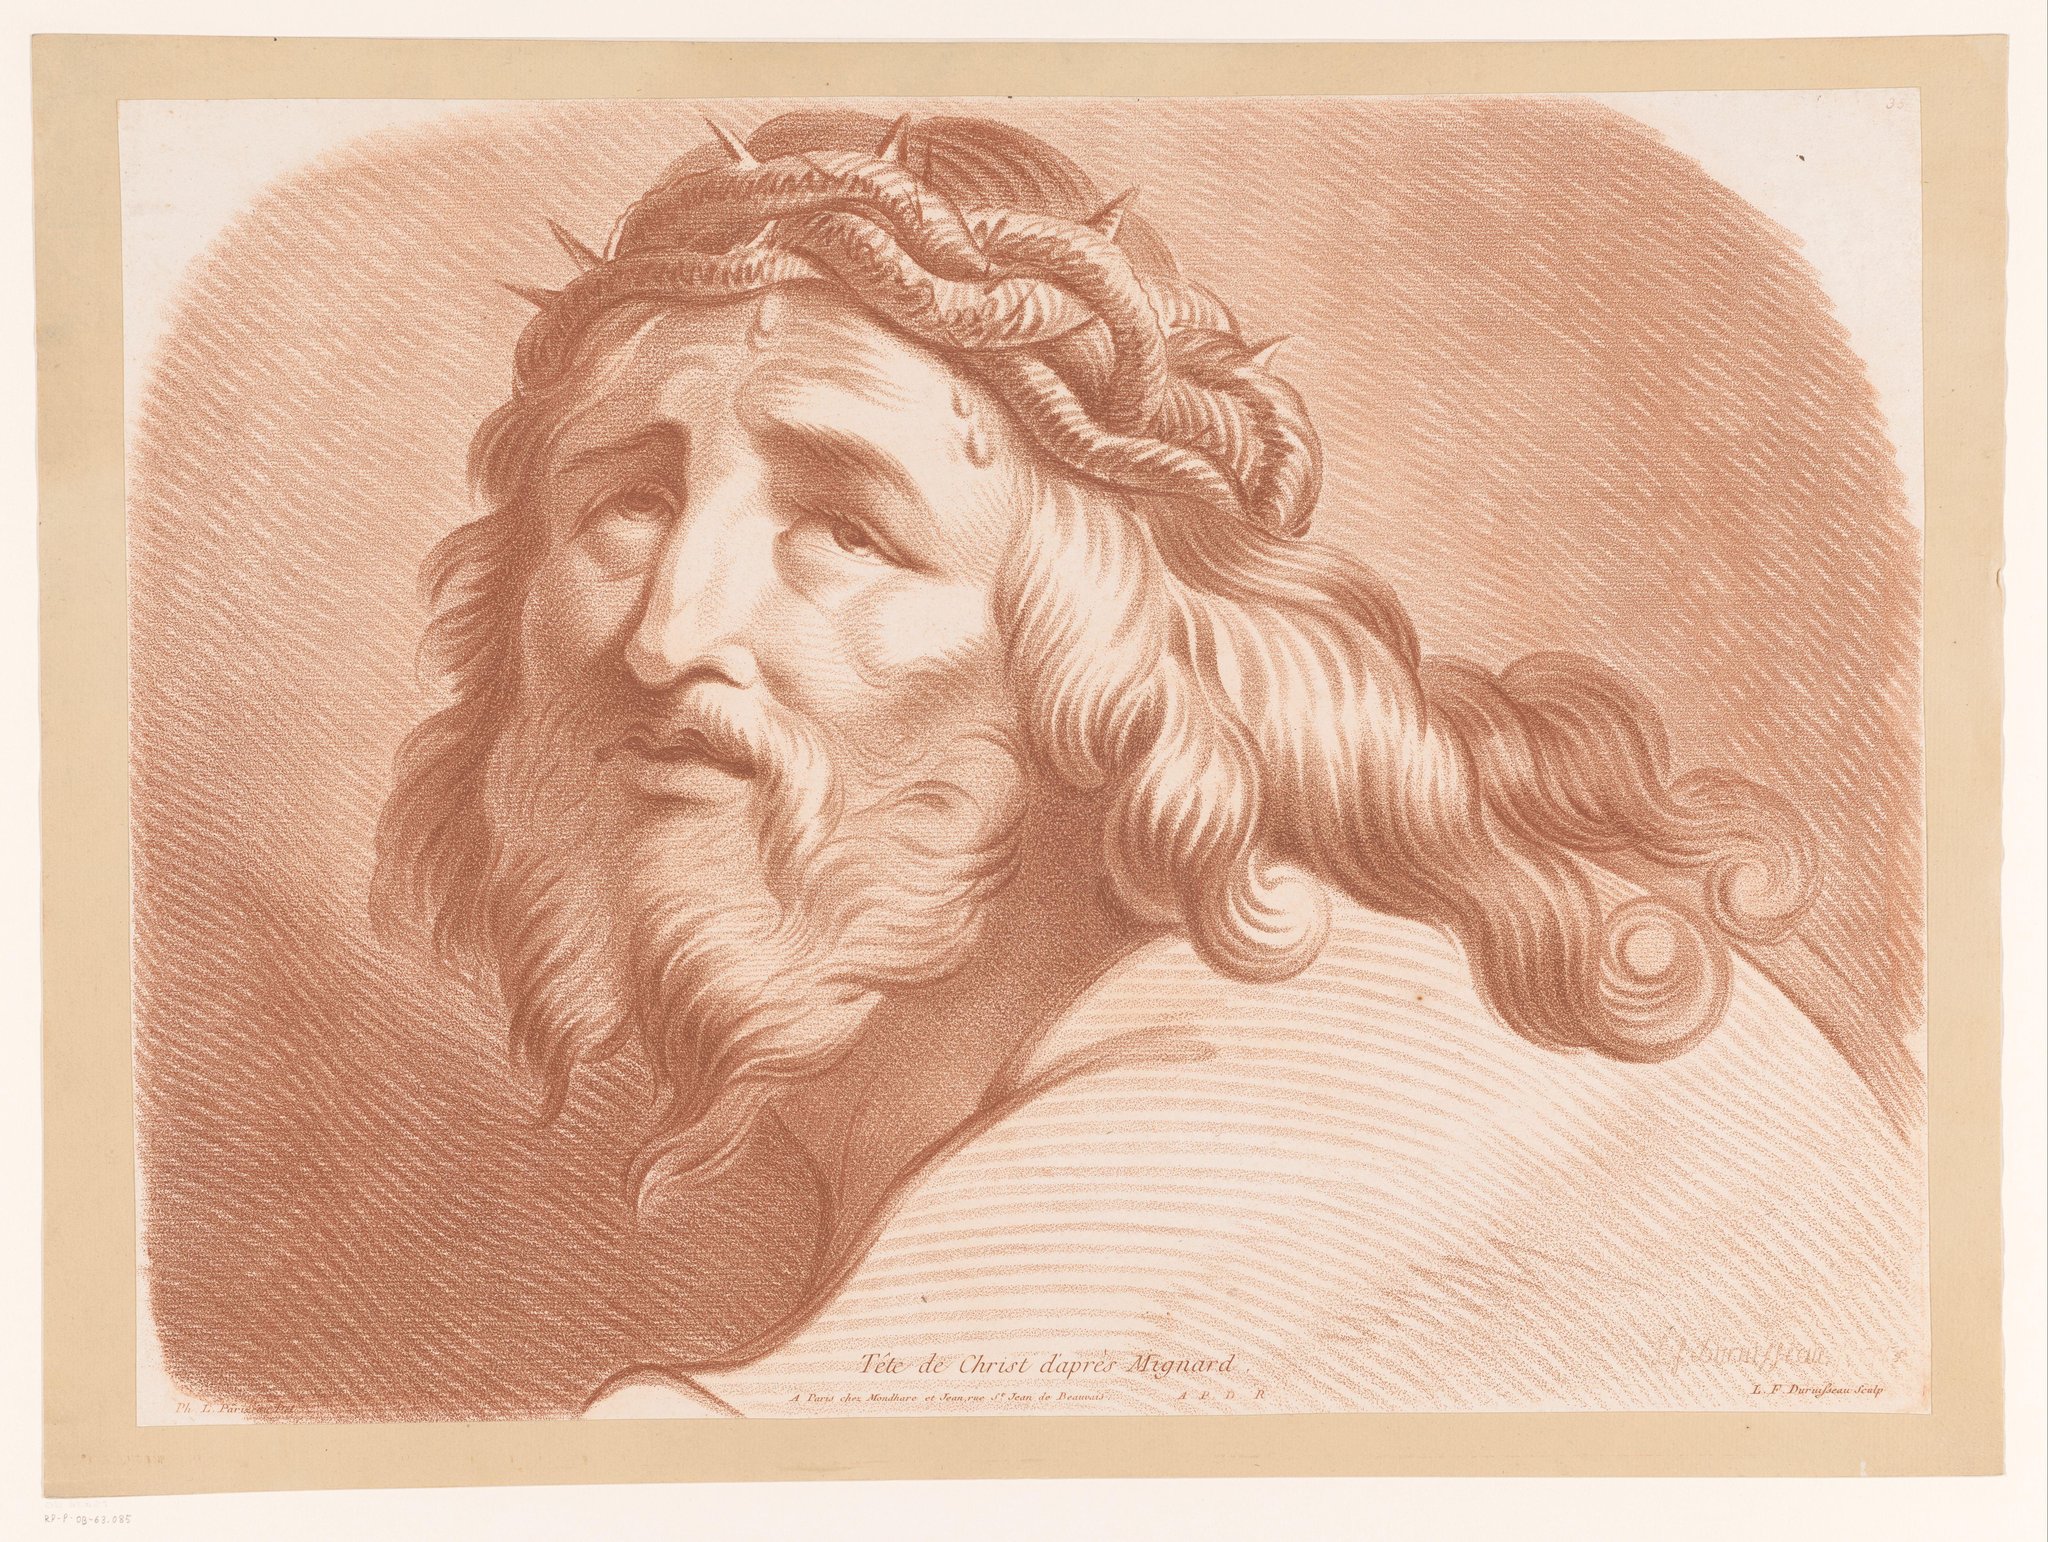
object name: print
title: Ecce homo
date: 1764-1803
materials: paper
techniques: printmaking, engraving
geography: paris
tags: christ alone (also called 'ecce homo')